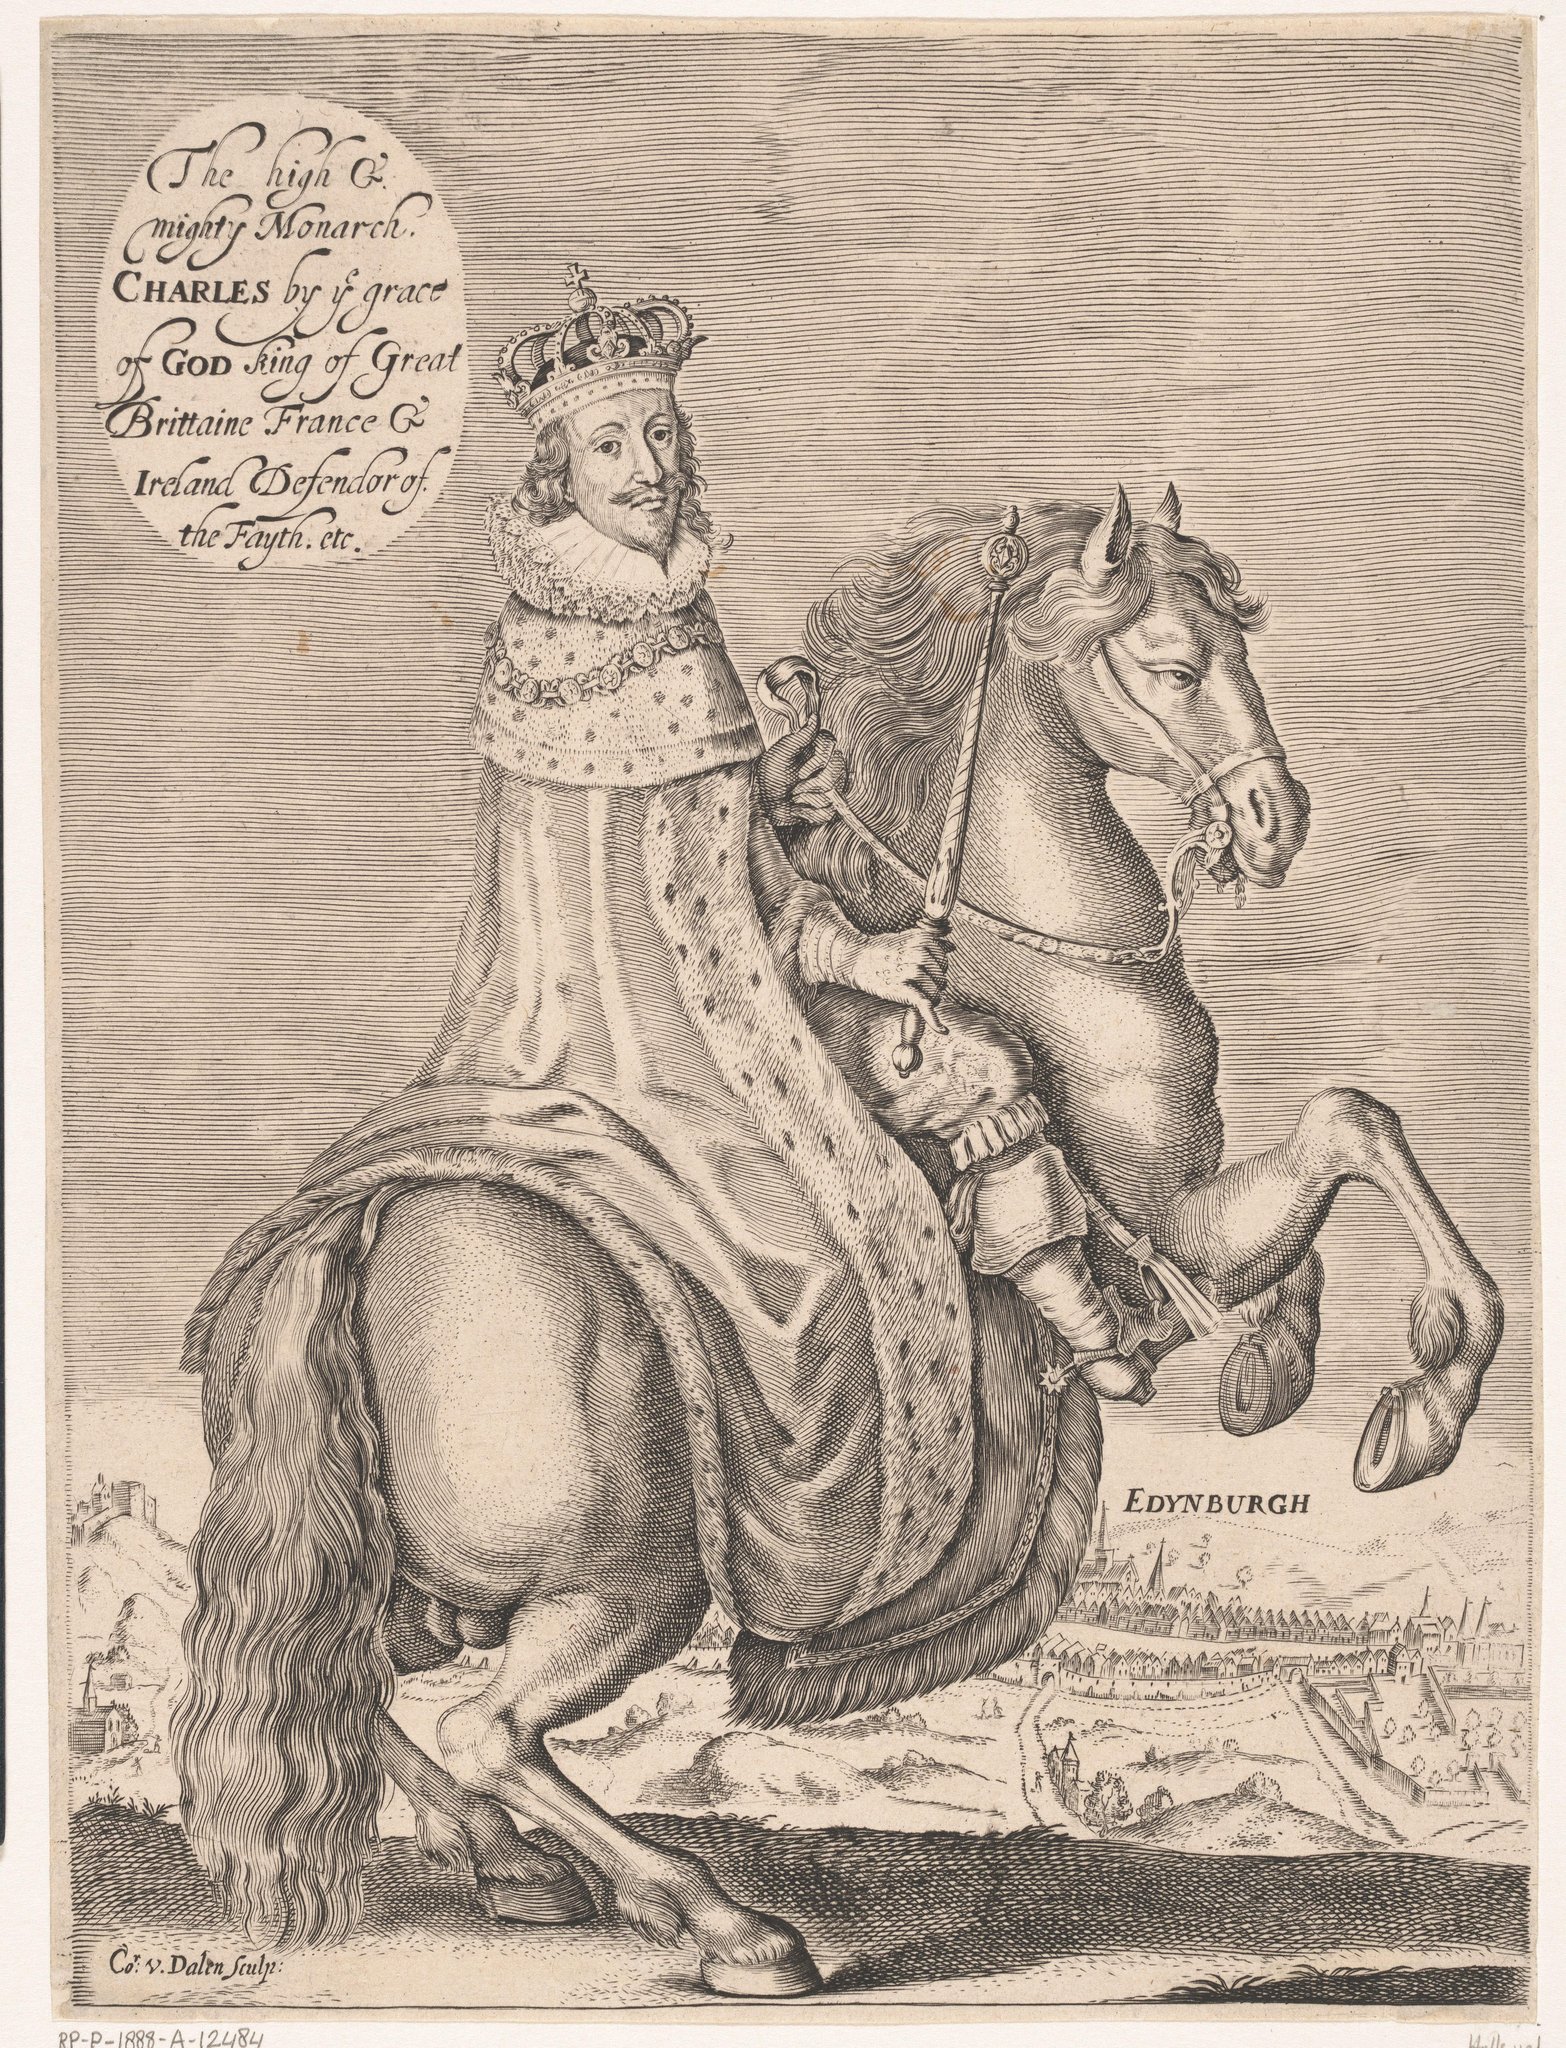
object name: print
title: De machtige heerser Karel met de zegen van God koning van Groot-Britannië, Frankrijk & Ierland, verdediger van het geloof, enz.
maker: cornelis van dalen (i)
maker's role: print maker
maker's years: 1602-1665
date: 1612-1665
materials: paper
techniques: engraving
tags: karel i (koning van engeland)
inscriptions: collector's mark: Lugt 2228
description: Ruiterportret van Karel I, Koning van Engeland, gekleed in koningsmantel, met kroon op zijn hoofd en scepter in zijn hand. In het landschap op de achtergrond ligt de plaats Edinburgh.